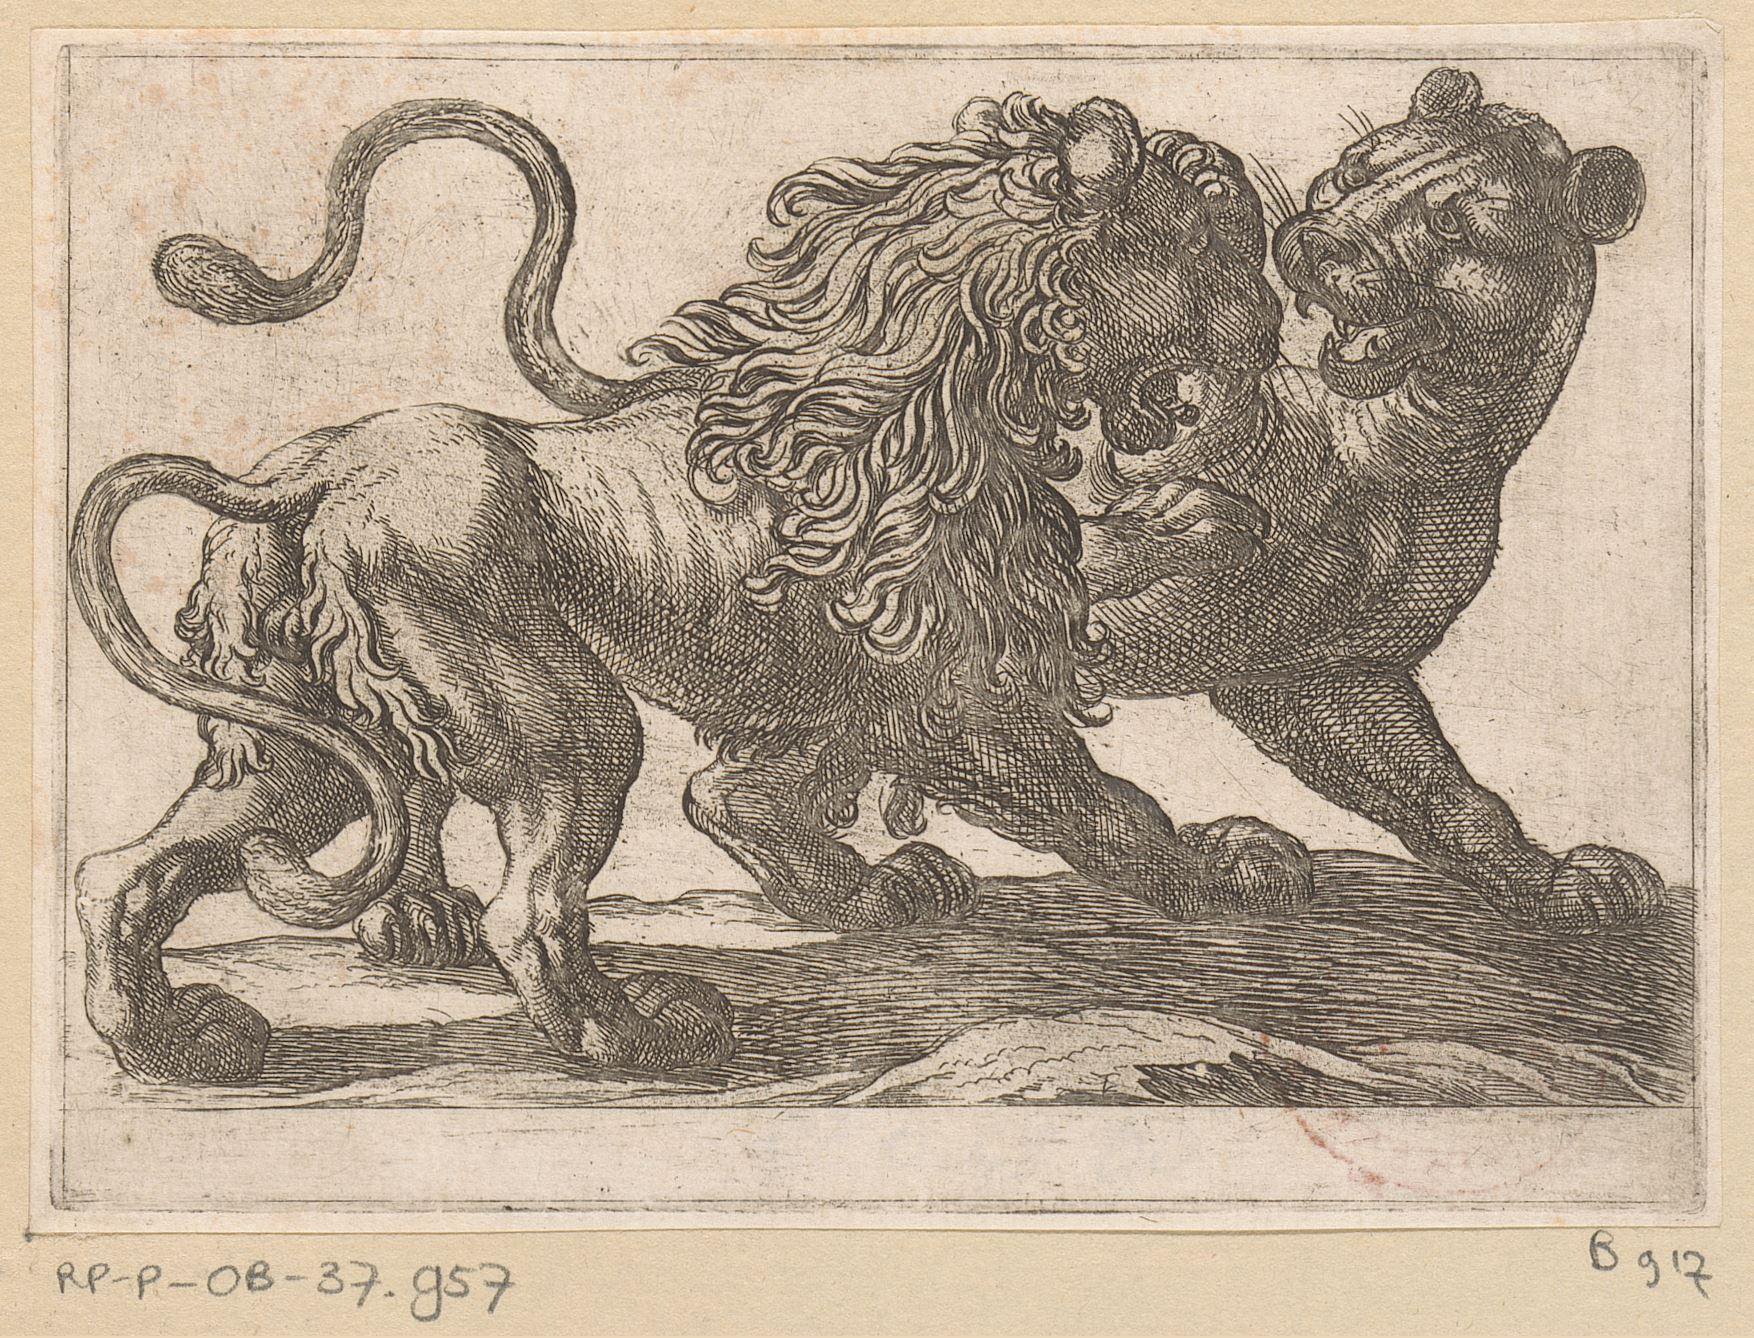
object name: print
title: Een leeuw vechtend met een leeuwin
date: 1600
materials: paper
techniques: etching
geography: rome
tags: beasts of prey, predatory animals: lion, fighting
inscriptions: collector's mark: Lugt 240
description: Deze prent maakt deel uit van een reeks van 25 prenten (+ titelprent) van vechtende dieren.